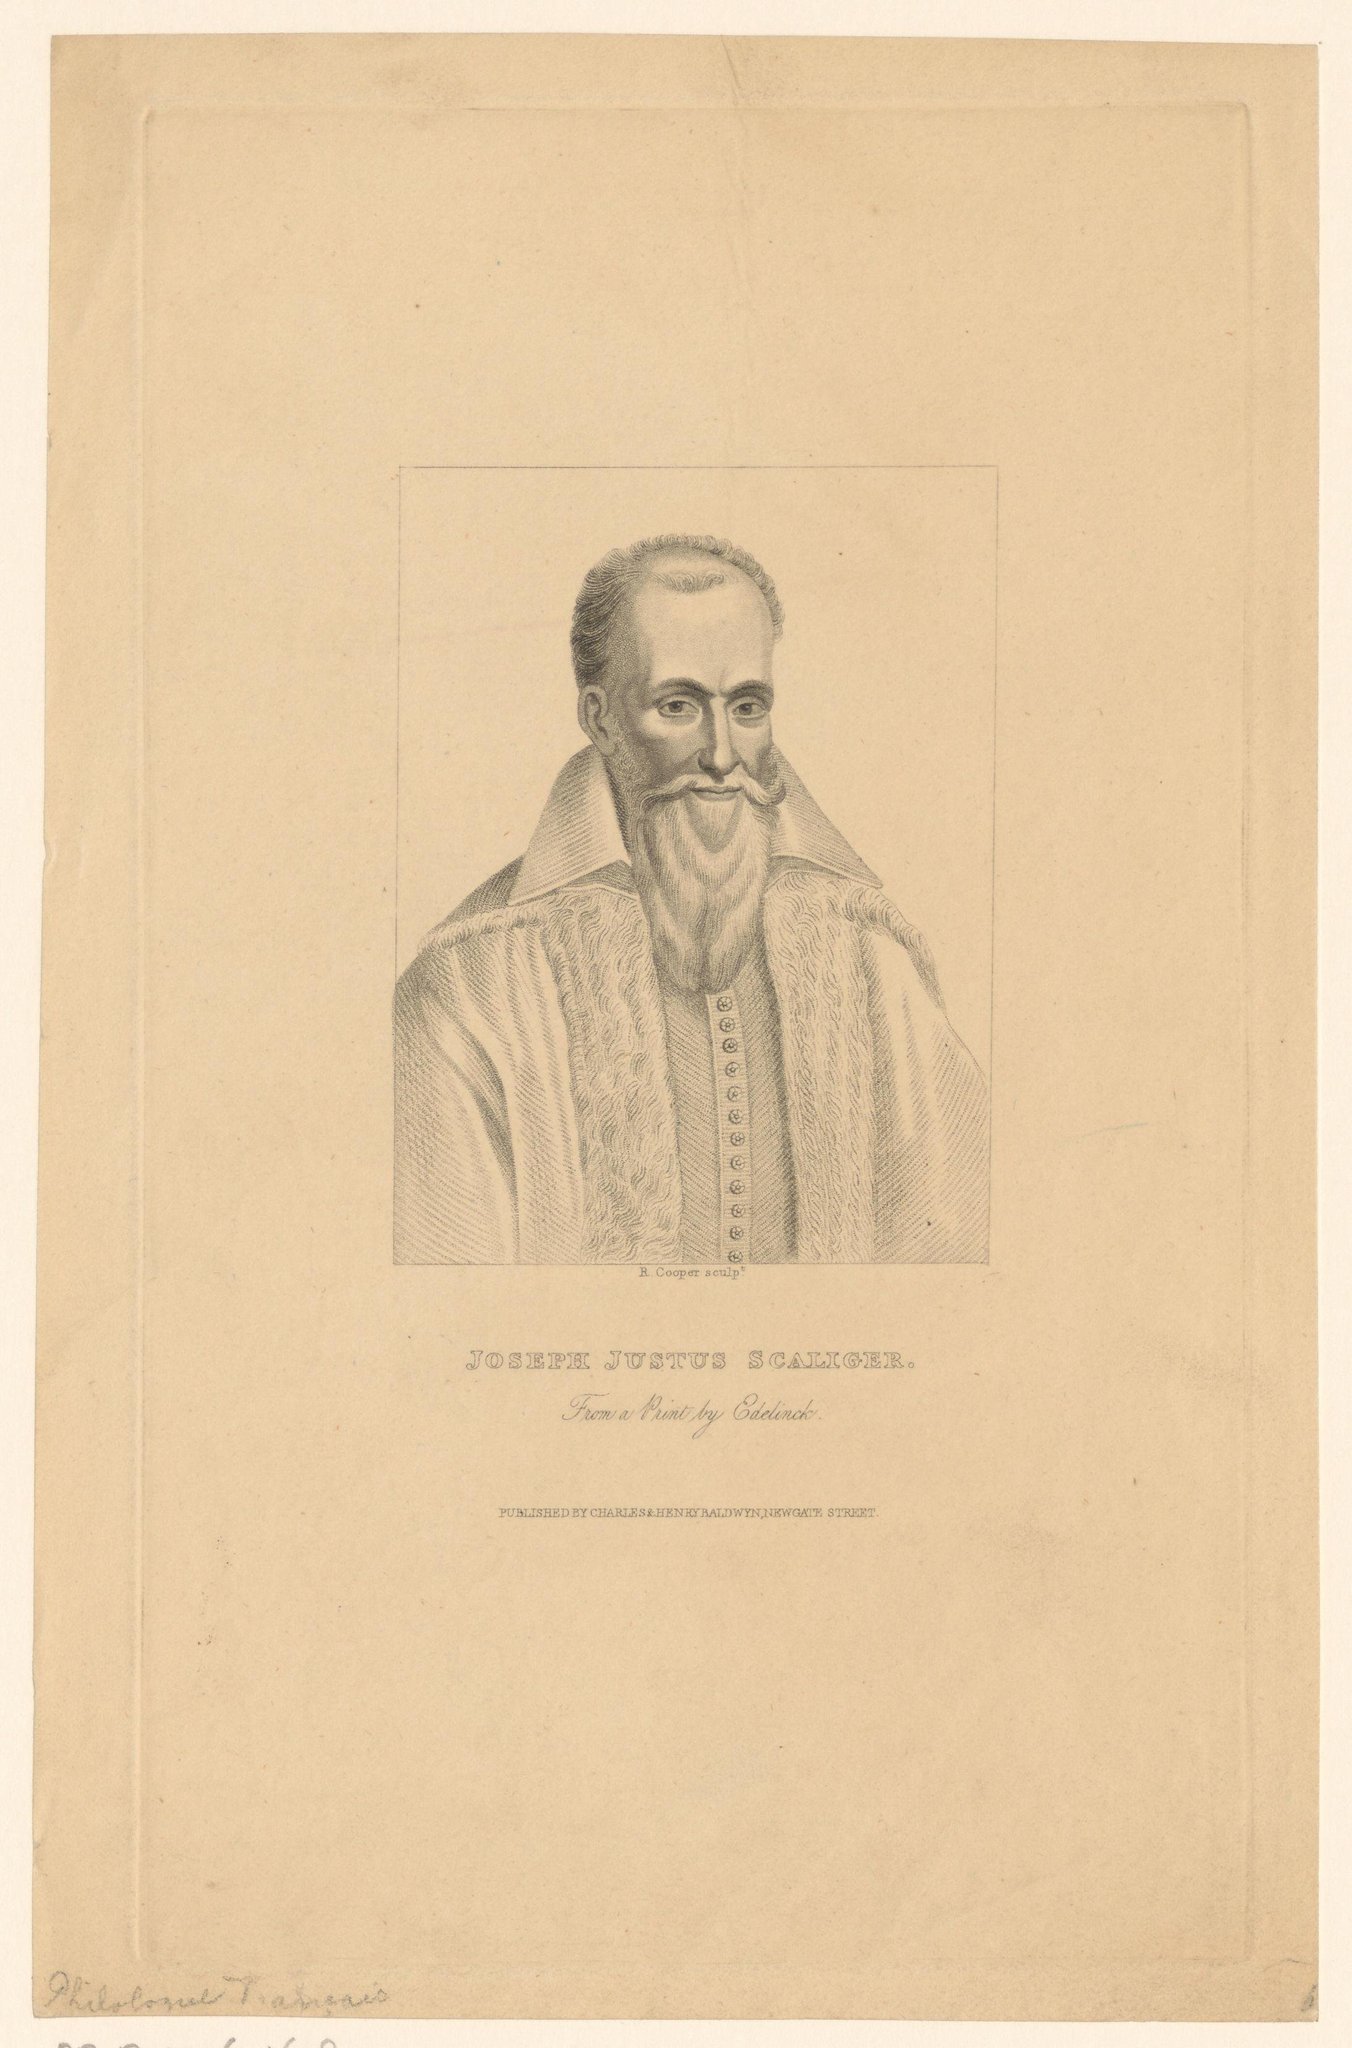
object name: print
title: Portret van Josephus Scaliger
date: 1817-1826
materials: paper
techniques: stippling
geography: london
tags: historical persons, scholar, philosopher (+ portrait of scholar, scientist)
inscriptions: collector's mark: Lugt 2228